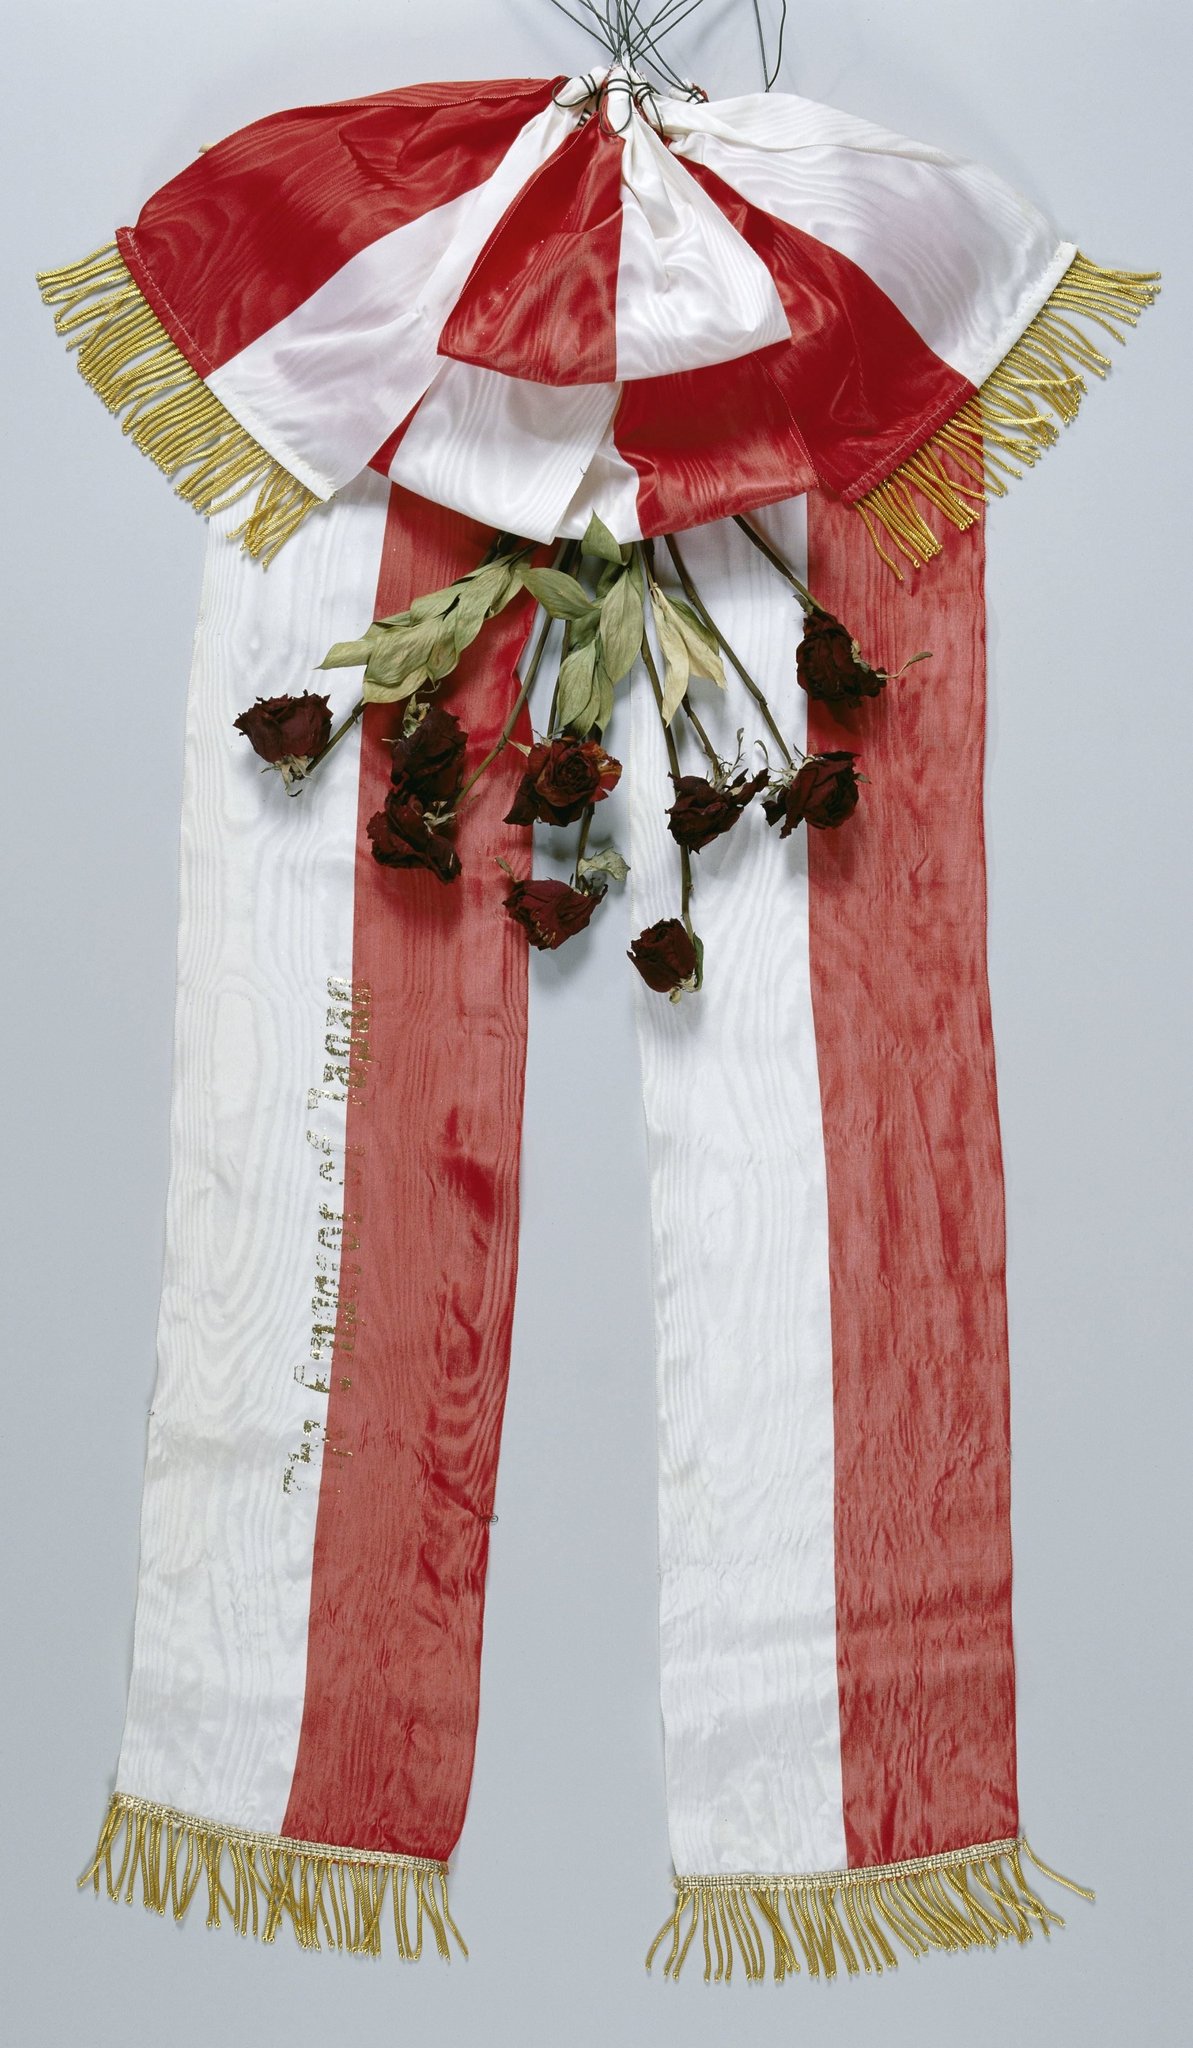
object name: ribbon material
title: Lint behorende bij de krans voor slachtoffers van het Japanse optreden tijdens de Tweede Wereldoorlog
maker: Anonymous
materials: gold leaf, textile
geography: netherlands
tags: japan, amsterdam, indonesia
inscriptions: inscription: ‘The Emperor of Japan’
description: Staatsbezoek van het Japanse keizerlijke paar in Nederland mei 2000. Het bezoek stond in het teken van de viering van de 400 jaar oude betrekkingen tussen Nederland en Japan. Zij legden een krans op 23 mei bij het Nationaal Monument op de Dam. Van de krans zijn een paar rode rozen bewaard en gedroogd (NG-2000-7).